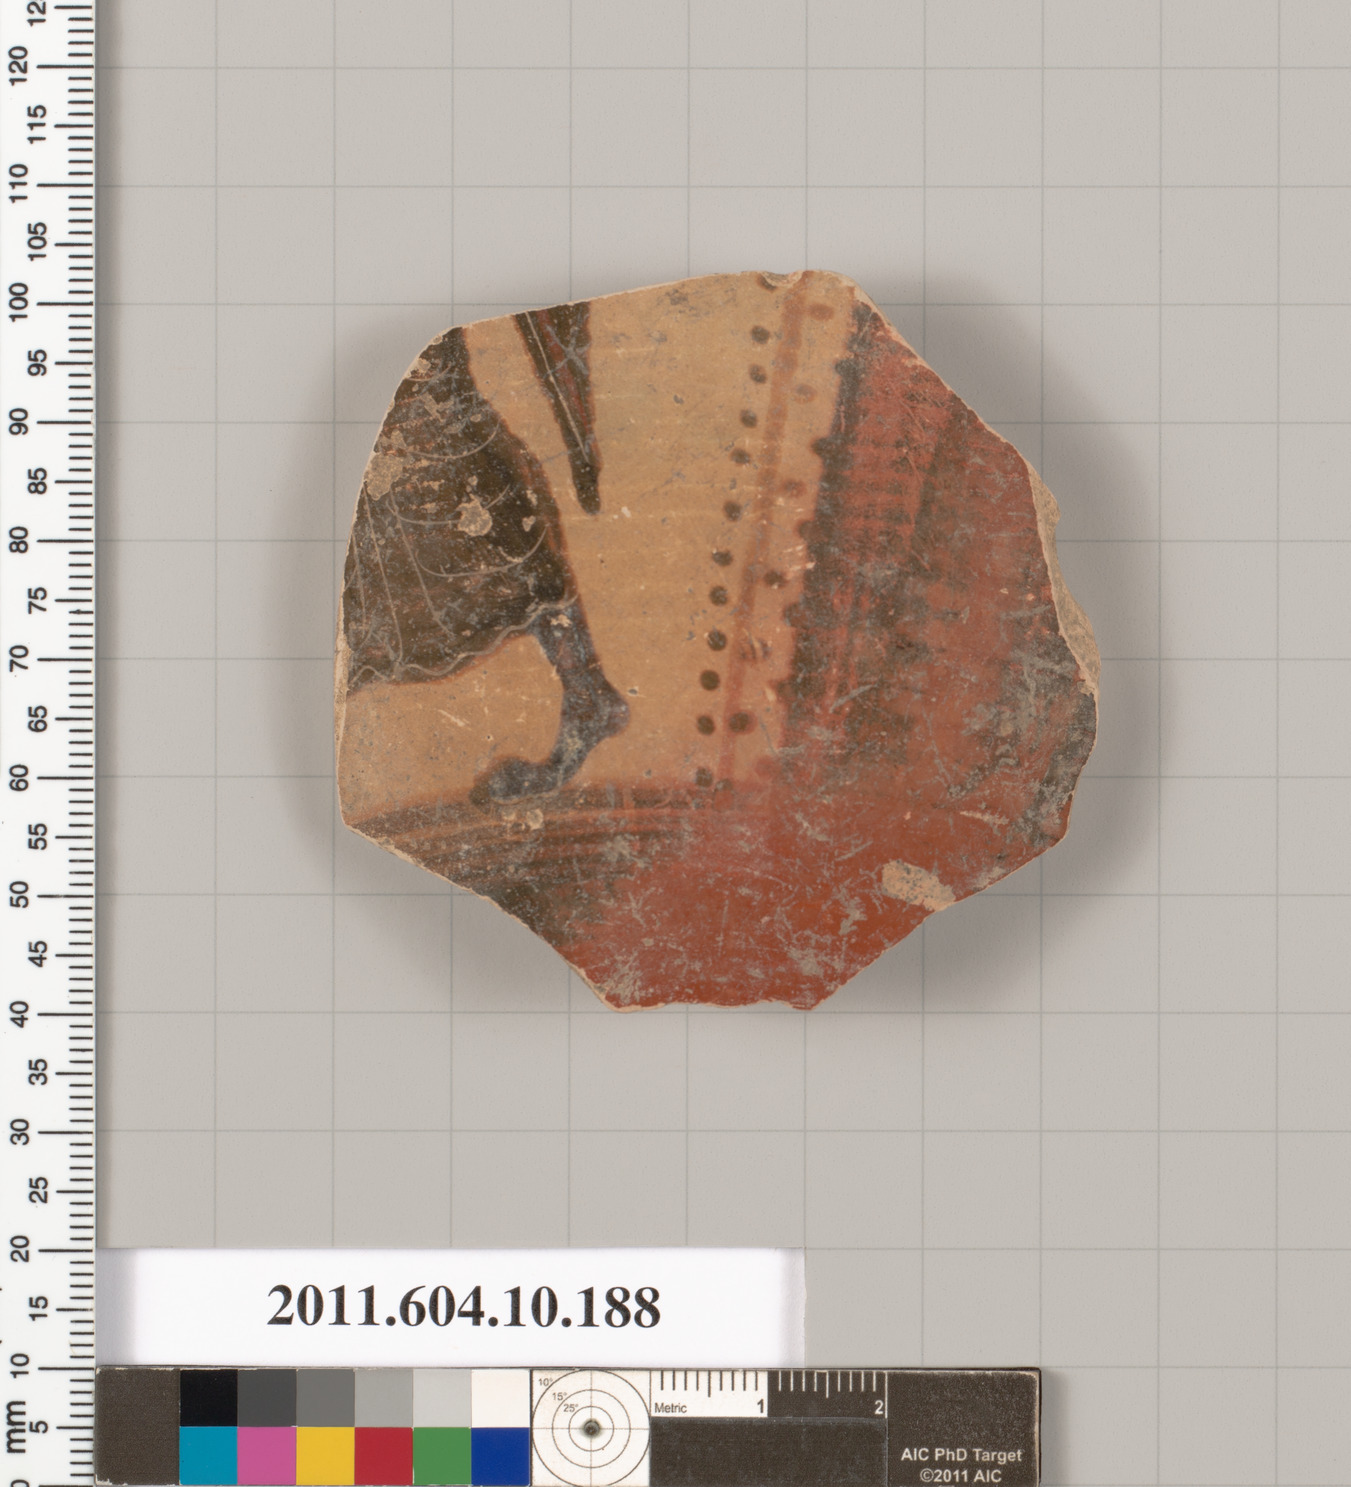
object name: undetermined closed shape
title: Terracotta fragment of a closed shape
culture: etruscan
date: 534-468 BCE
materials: terracotta